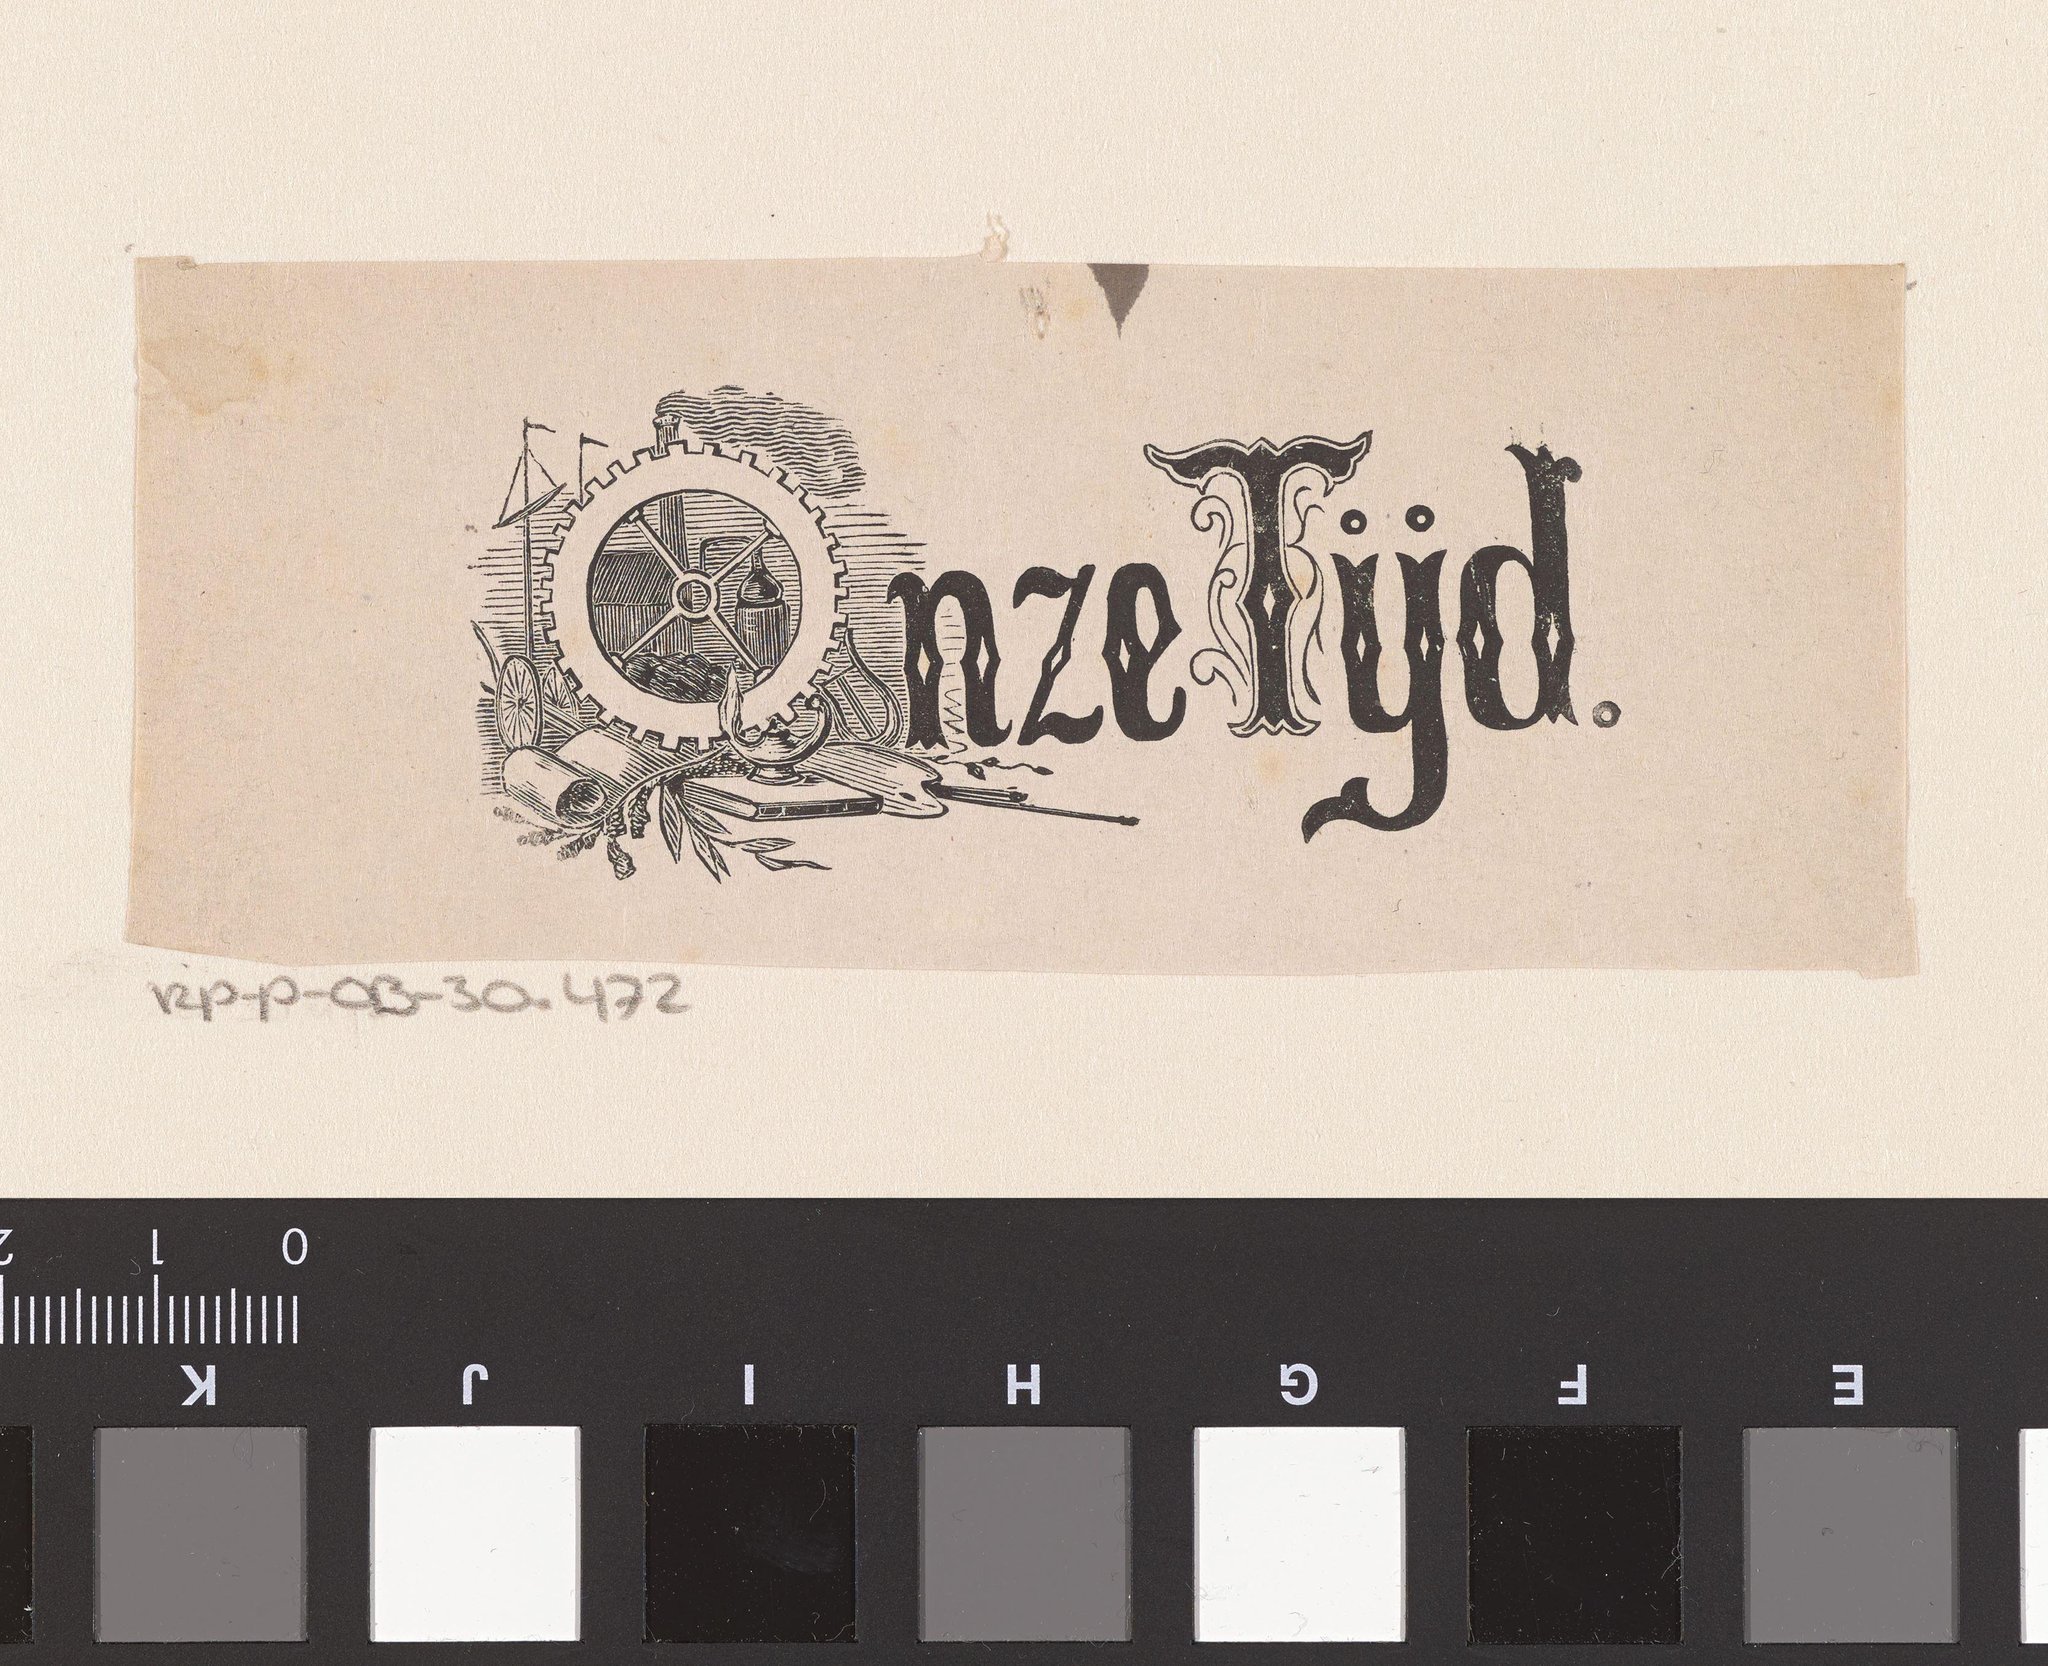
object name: print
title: Onze tijd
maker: isaac weissenbruch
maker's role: print maker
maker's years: 1826-1912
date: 1836-1912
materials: paper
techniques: engraving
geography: netherlands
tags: factory-building, globe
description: Een aantal objecten uit de negentiende eeuw, waaronder een tandwiel en een fabriek.